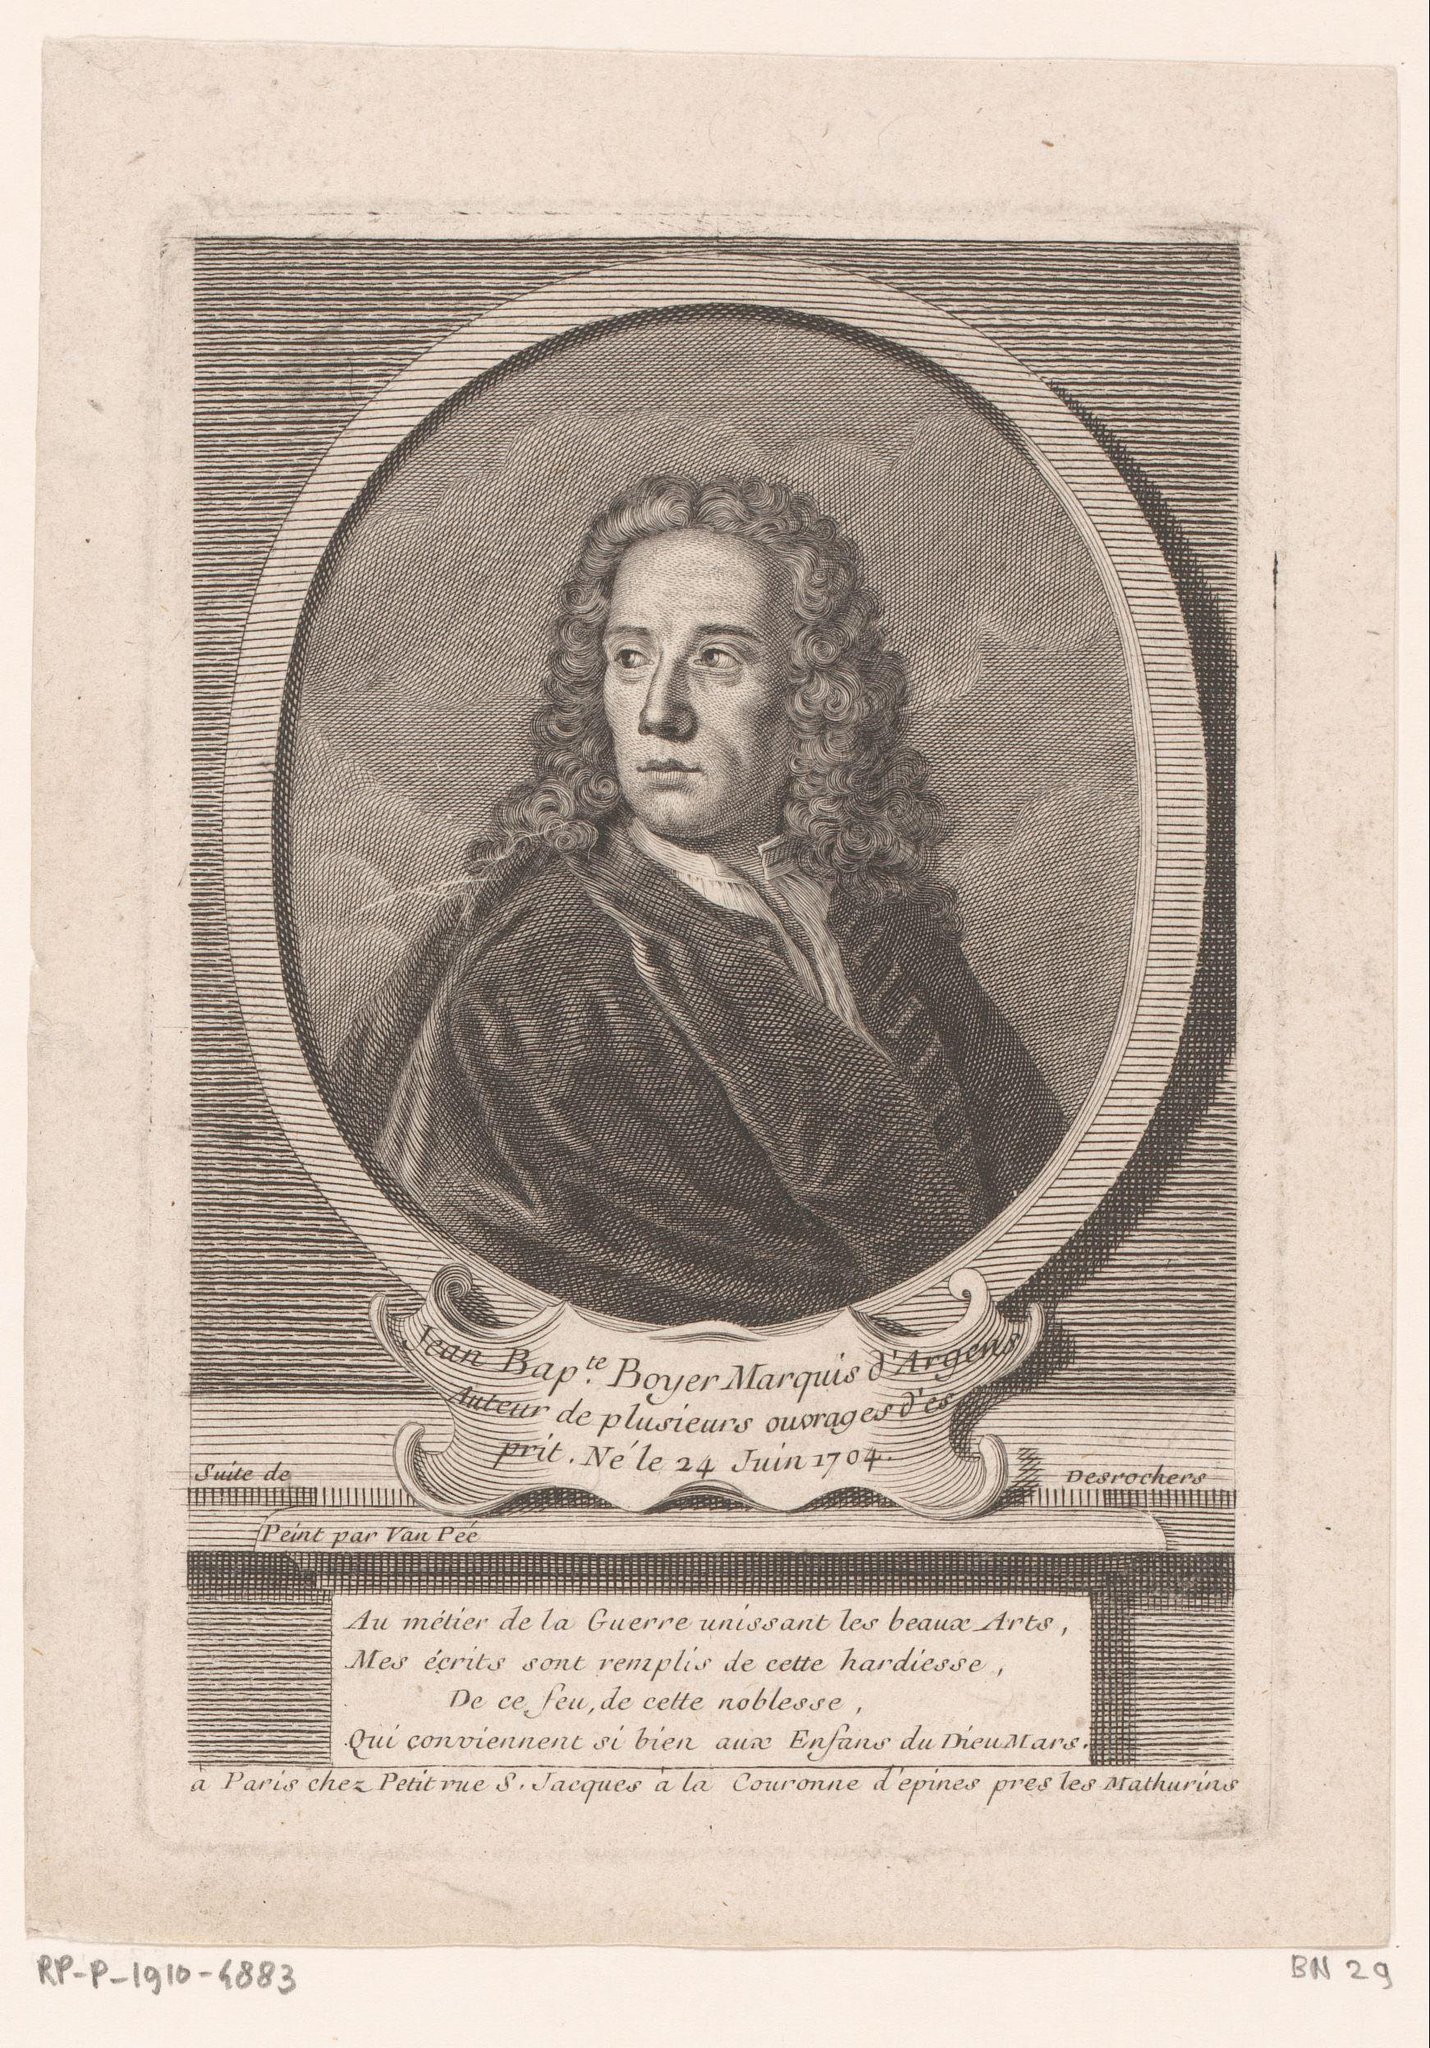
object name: print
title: Portret van Jean-Baptiste de Boyer, Marquis d'Argens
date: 1726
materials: paper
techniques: engraving, etching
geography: paris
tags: toulon, scholar, philosopher, historical persons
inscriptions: collector's mark: Lugt 2228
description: Behoort waarschijnlijk tot een serie portretten, grotendeels door Etienne Desrochers, getiteld: 'Recueil de portraits de personnes qui se sont distinguées tant dans les Armes que dans Belles-Lettres et les Arts, comme aussi la famille royale de France et autres cours étrangères'. De serie werd initieel uitgegeven door Desrochers en aangekondigd in 'Mercure' in mei 1726, p. 985. Echter was Desrochers reeds enkele jaren eerder begonnen met het uitgeven van de serie. Na de dood van Desrochers werd de serie voortgezet door Gilles Edme Petit. Een latere staat werd uitgegeven door Jean François Daumont in Parijs.